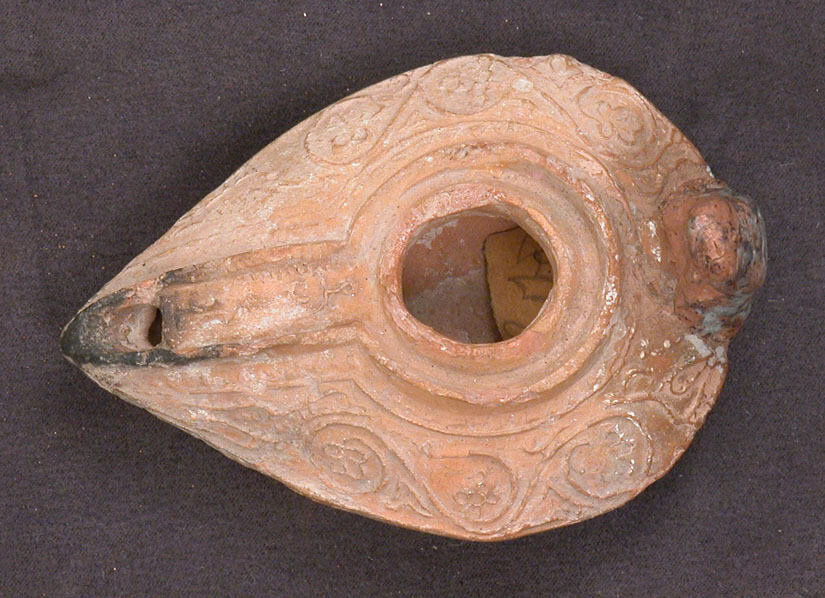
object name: lamp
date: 601-1100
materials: earthenware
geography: palestine